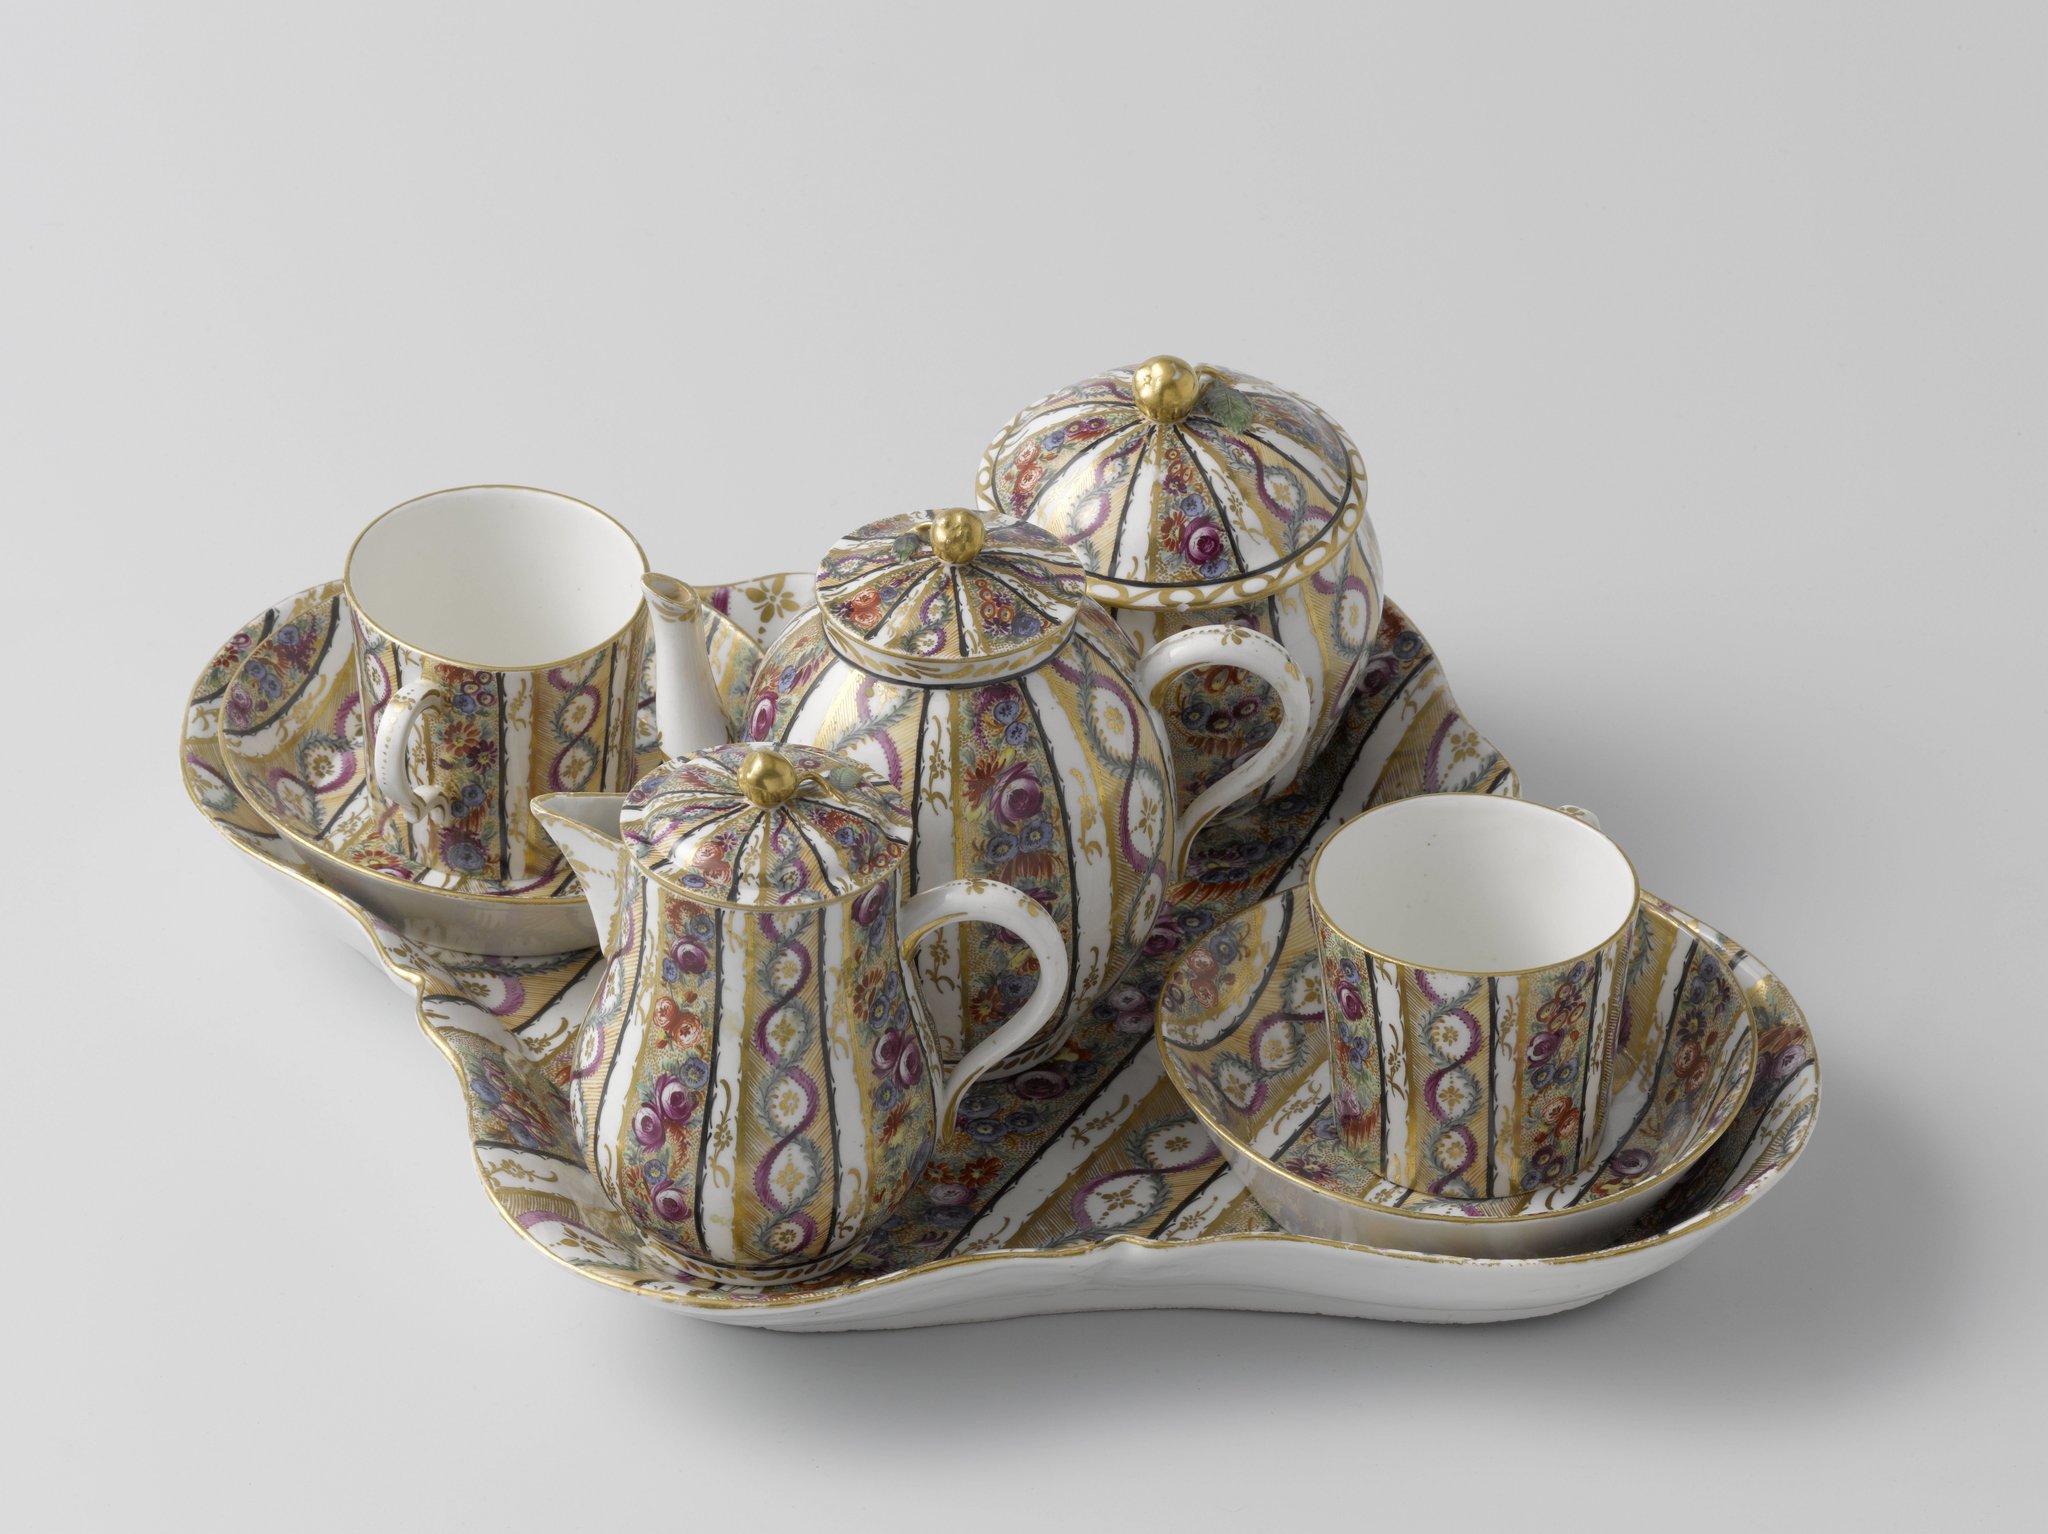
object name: tea service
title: Tea service for two people (tête-à-tête)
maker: louis victor gerverot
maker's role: ceramicist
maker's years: 1747-1829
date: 1773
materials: glaze, gold, paint, porcelain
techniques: firing, forming, gilding, vitrification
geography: schrezheim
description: Shortly before the Loosdrecht factory was founded, the porcelain painter Louis Gerverot, formerly active in Weesp, made some sample pieces. This allowed factory owner Johannes de Mol to see whether he was suited to run the business. Gerverot misled De Mol, however; instead of making his own service, he bought a piece in Höchst, Germany, and simply painted it.